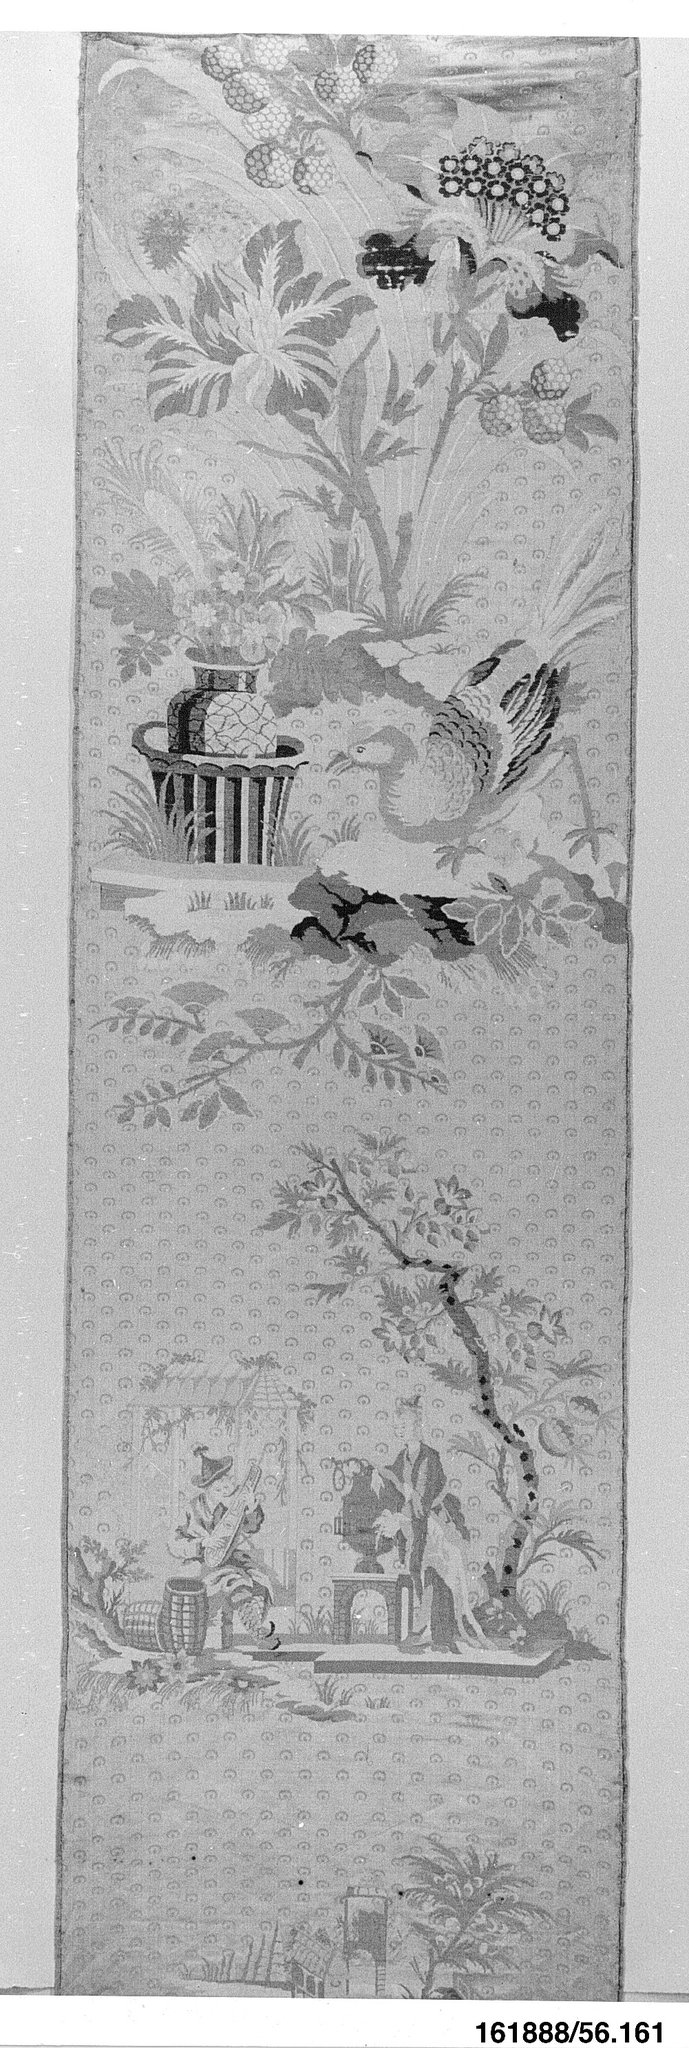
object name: piece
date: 1760-1770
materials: silk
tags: birds,flowers,leaves